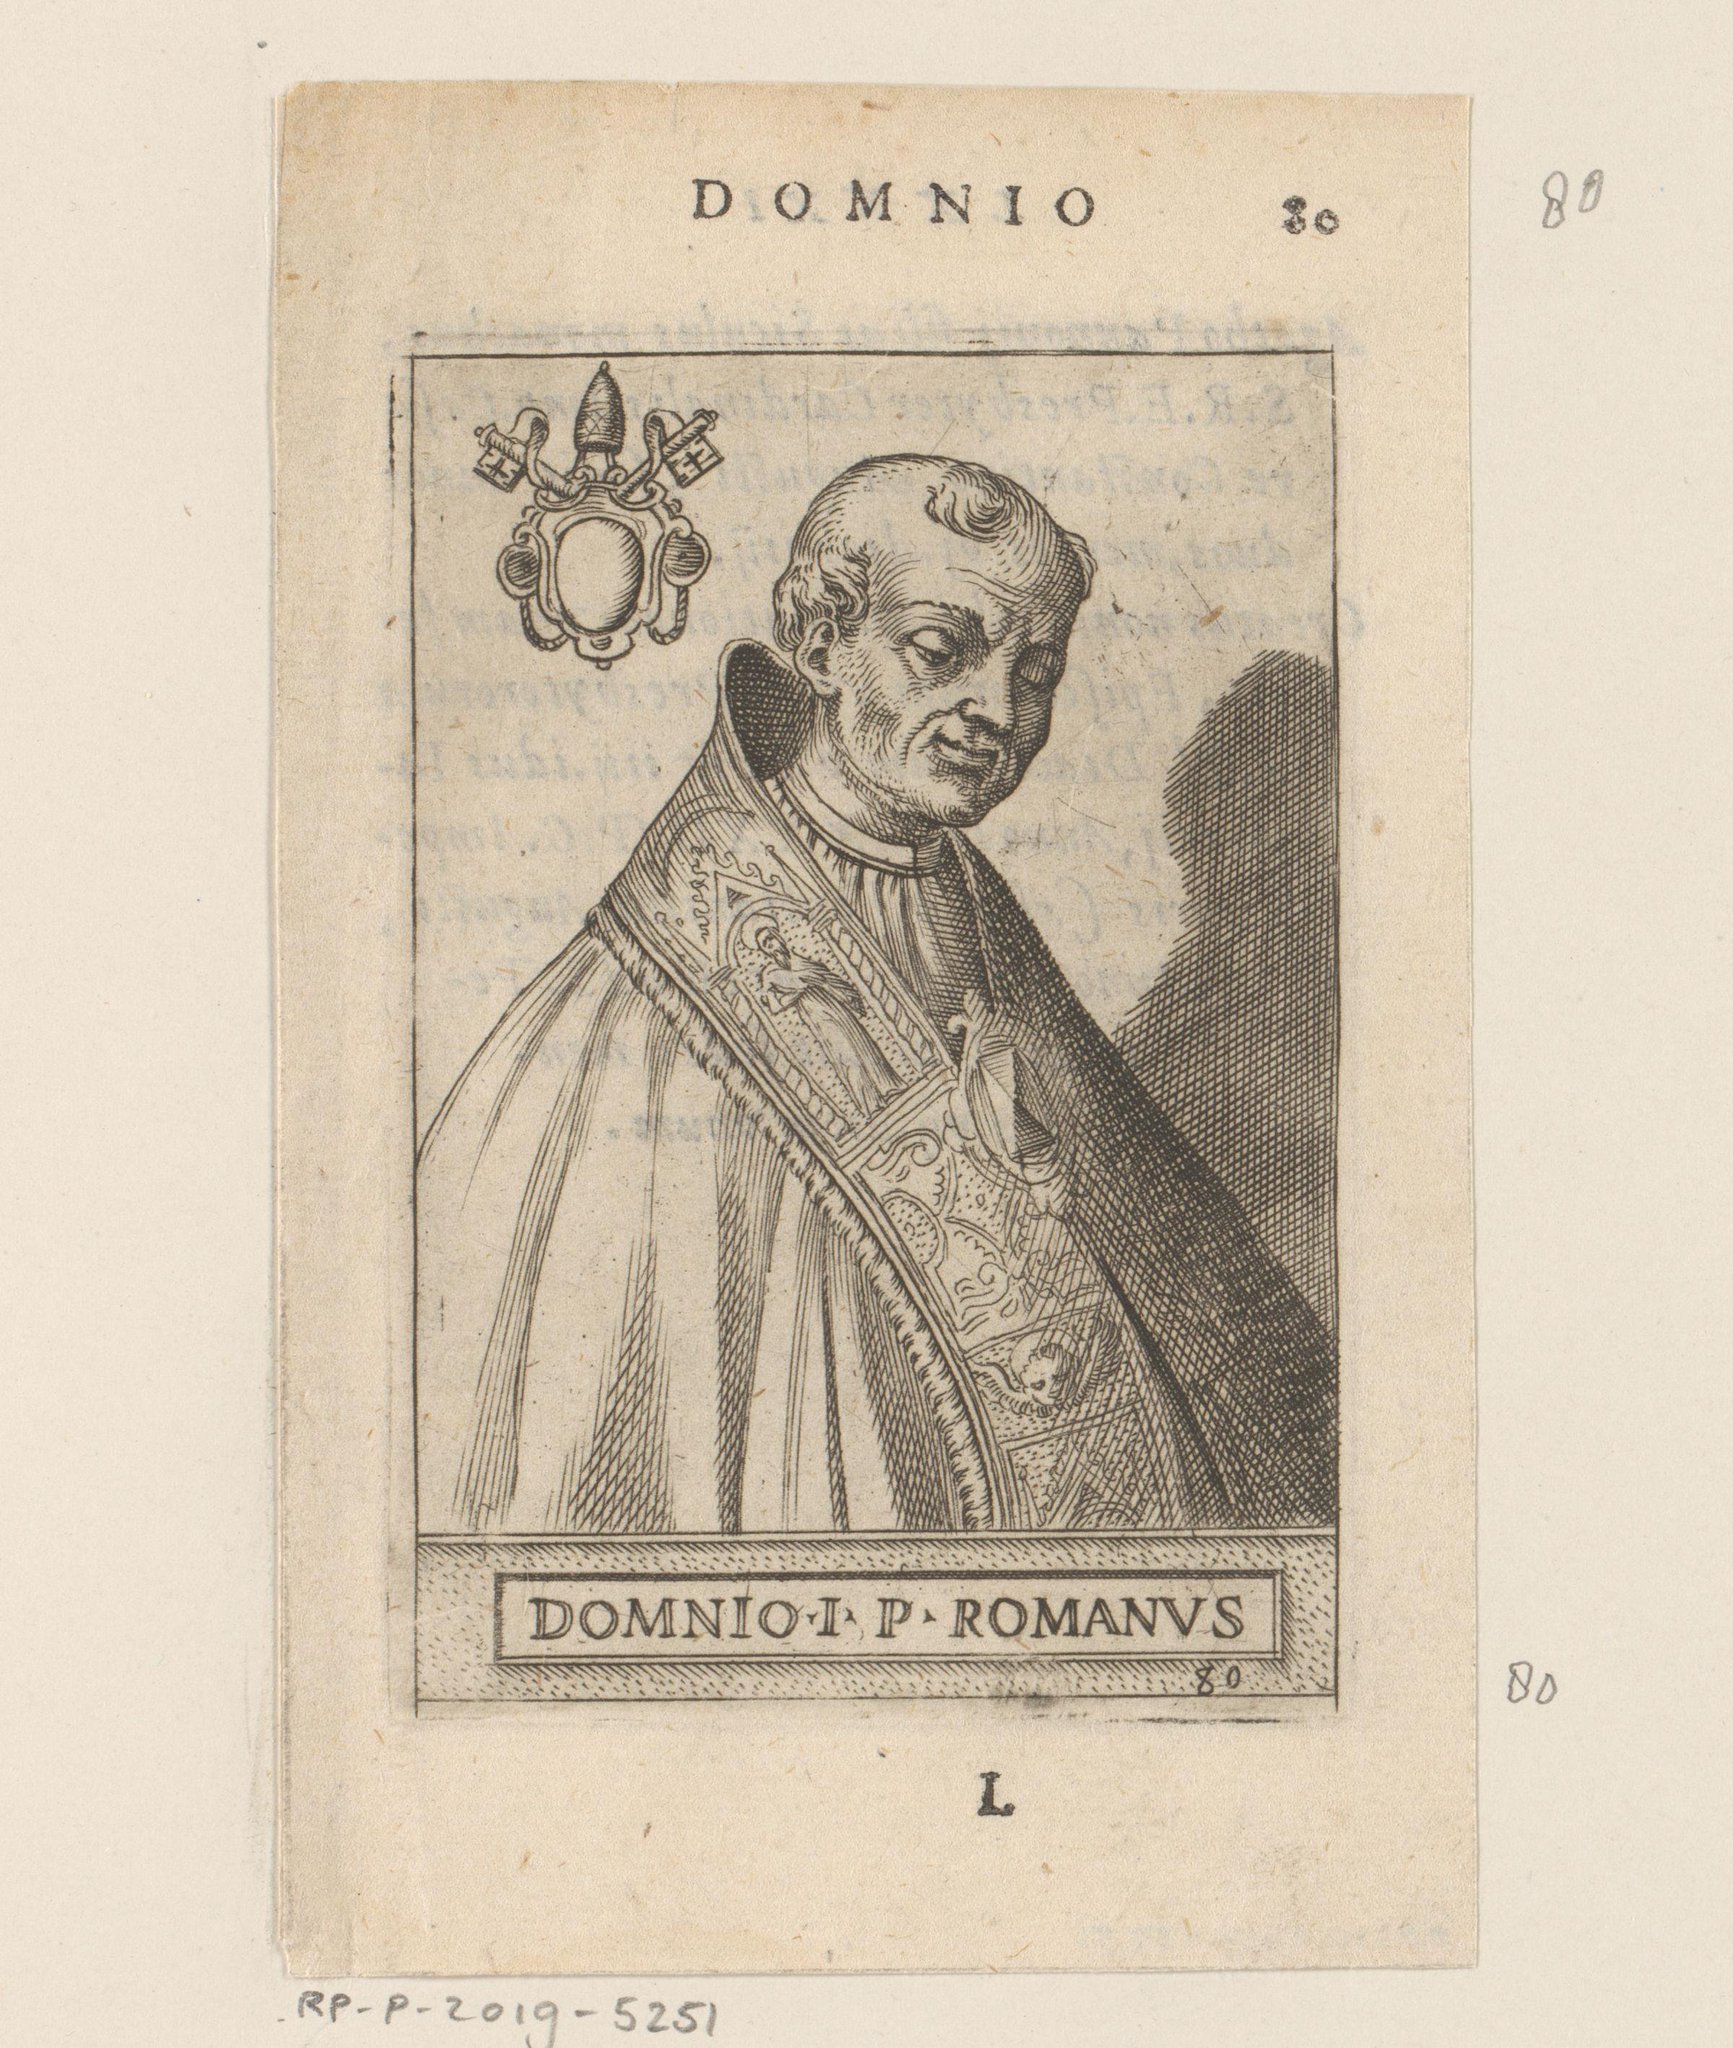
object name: print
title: Portret van paus Donus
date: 1595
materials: paper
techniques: engraving, letterpress printing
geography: rome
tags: historical persons, pope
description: Prent uit: Cavalieri, Giovanni Battista de'. Effigies pontificum romanorum cum eorum vitis (...). Rome: Bartolomeo Bonfadino, 1595. Prent voor het eerst verschenen in: Cavalieri, Giovanni Battista de'. Pontificum romanorum effigies (...). Rome: Domenico Basa en Francesco Zanetti, 1580. Prent ook gebruikt in latere publicaties.